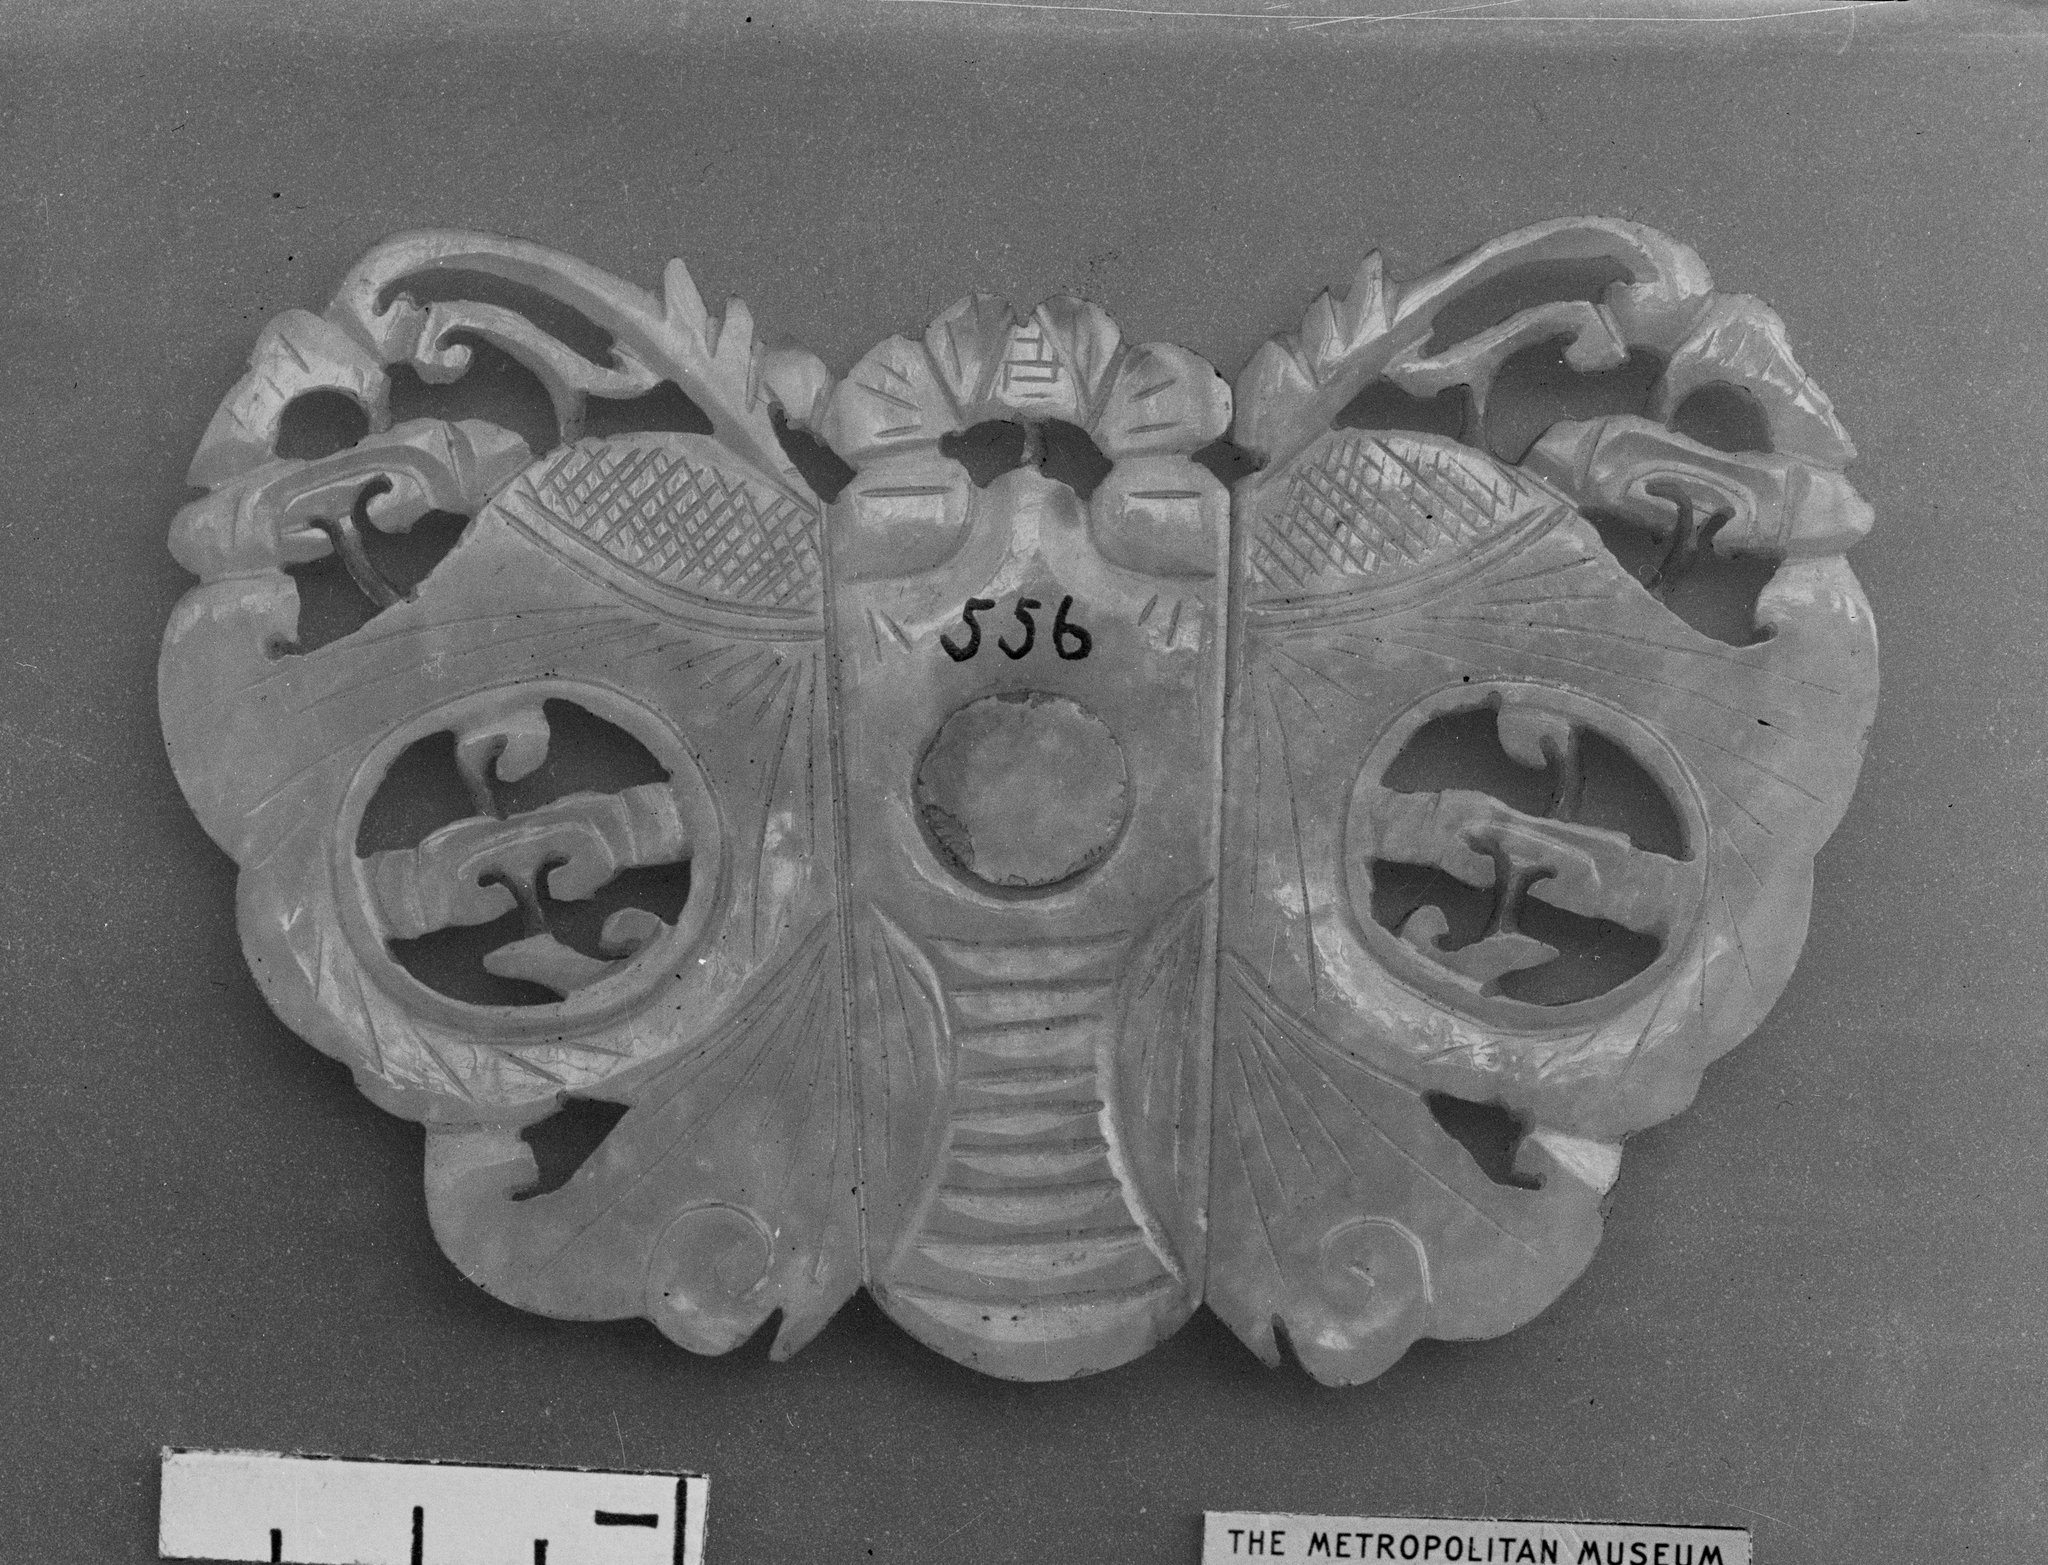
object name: girdle buckle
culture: chinese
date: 1736-1795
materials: jade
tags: insects